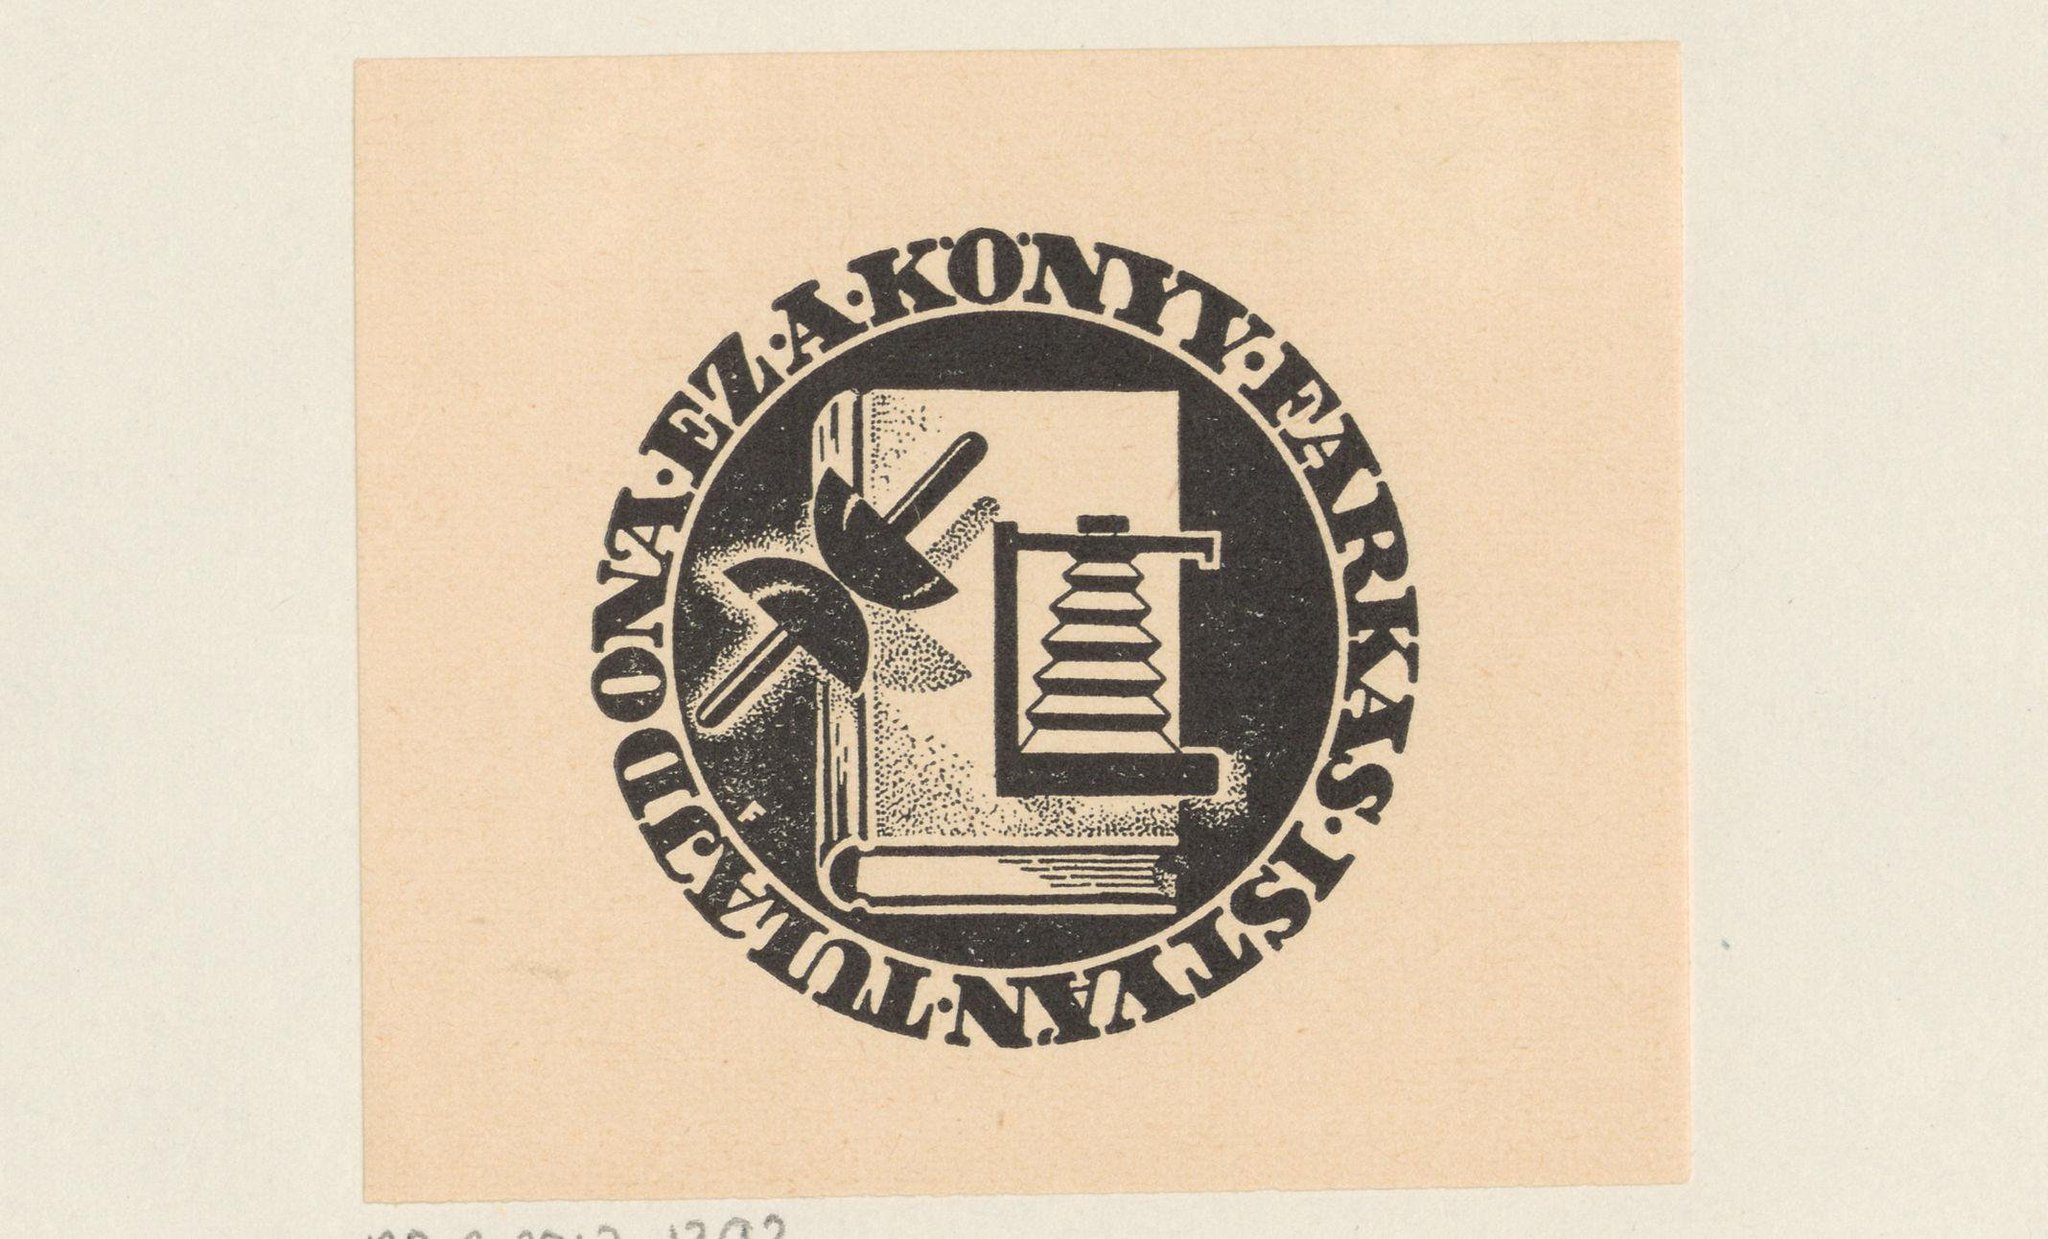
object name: bookplate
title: Ex libris van István Farkas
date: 1900-1944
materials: paper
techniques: printing block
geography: hungary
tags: painter, camera ~ photography, tools, implements of graphic artist, book